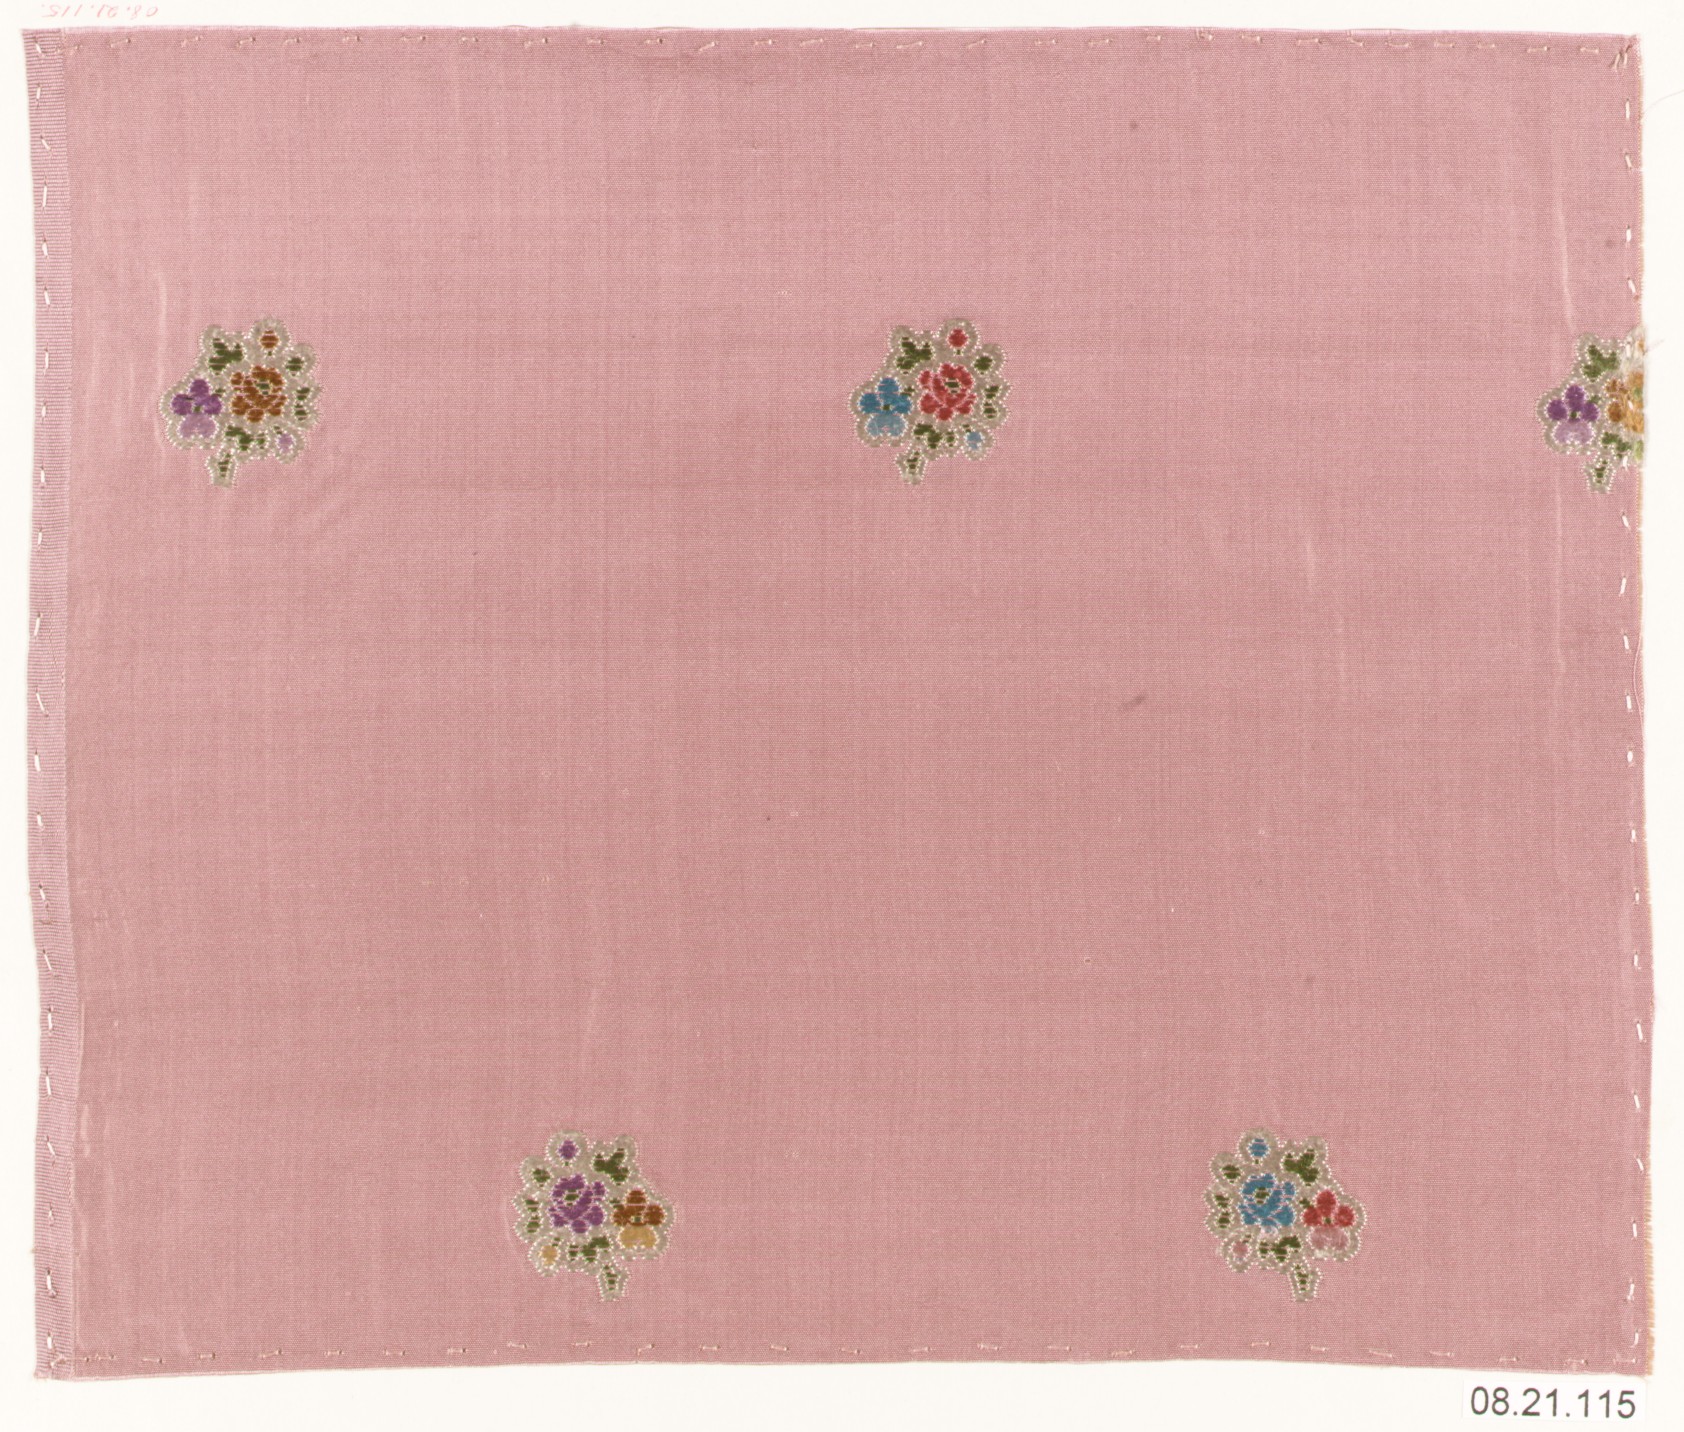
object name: textile sample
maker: Anonymous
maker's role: designer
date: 1900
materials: silk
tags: flowers